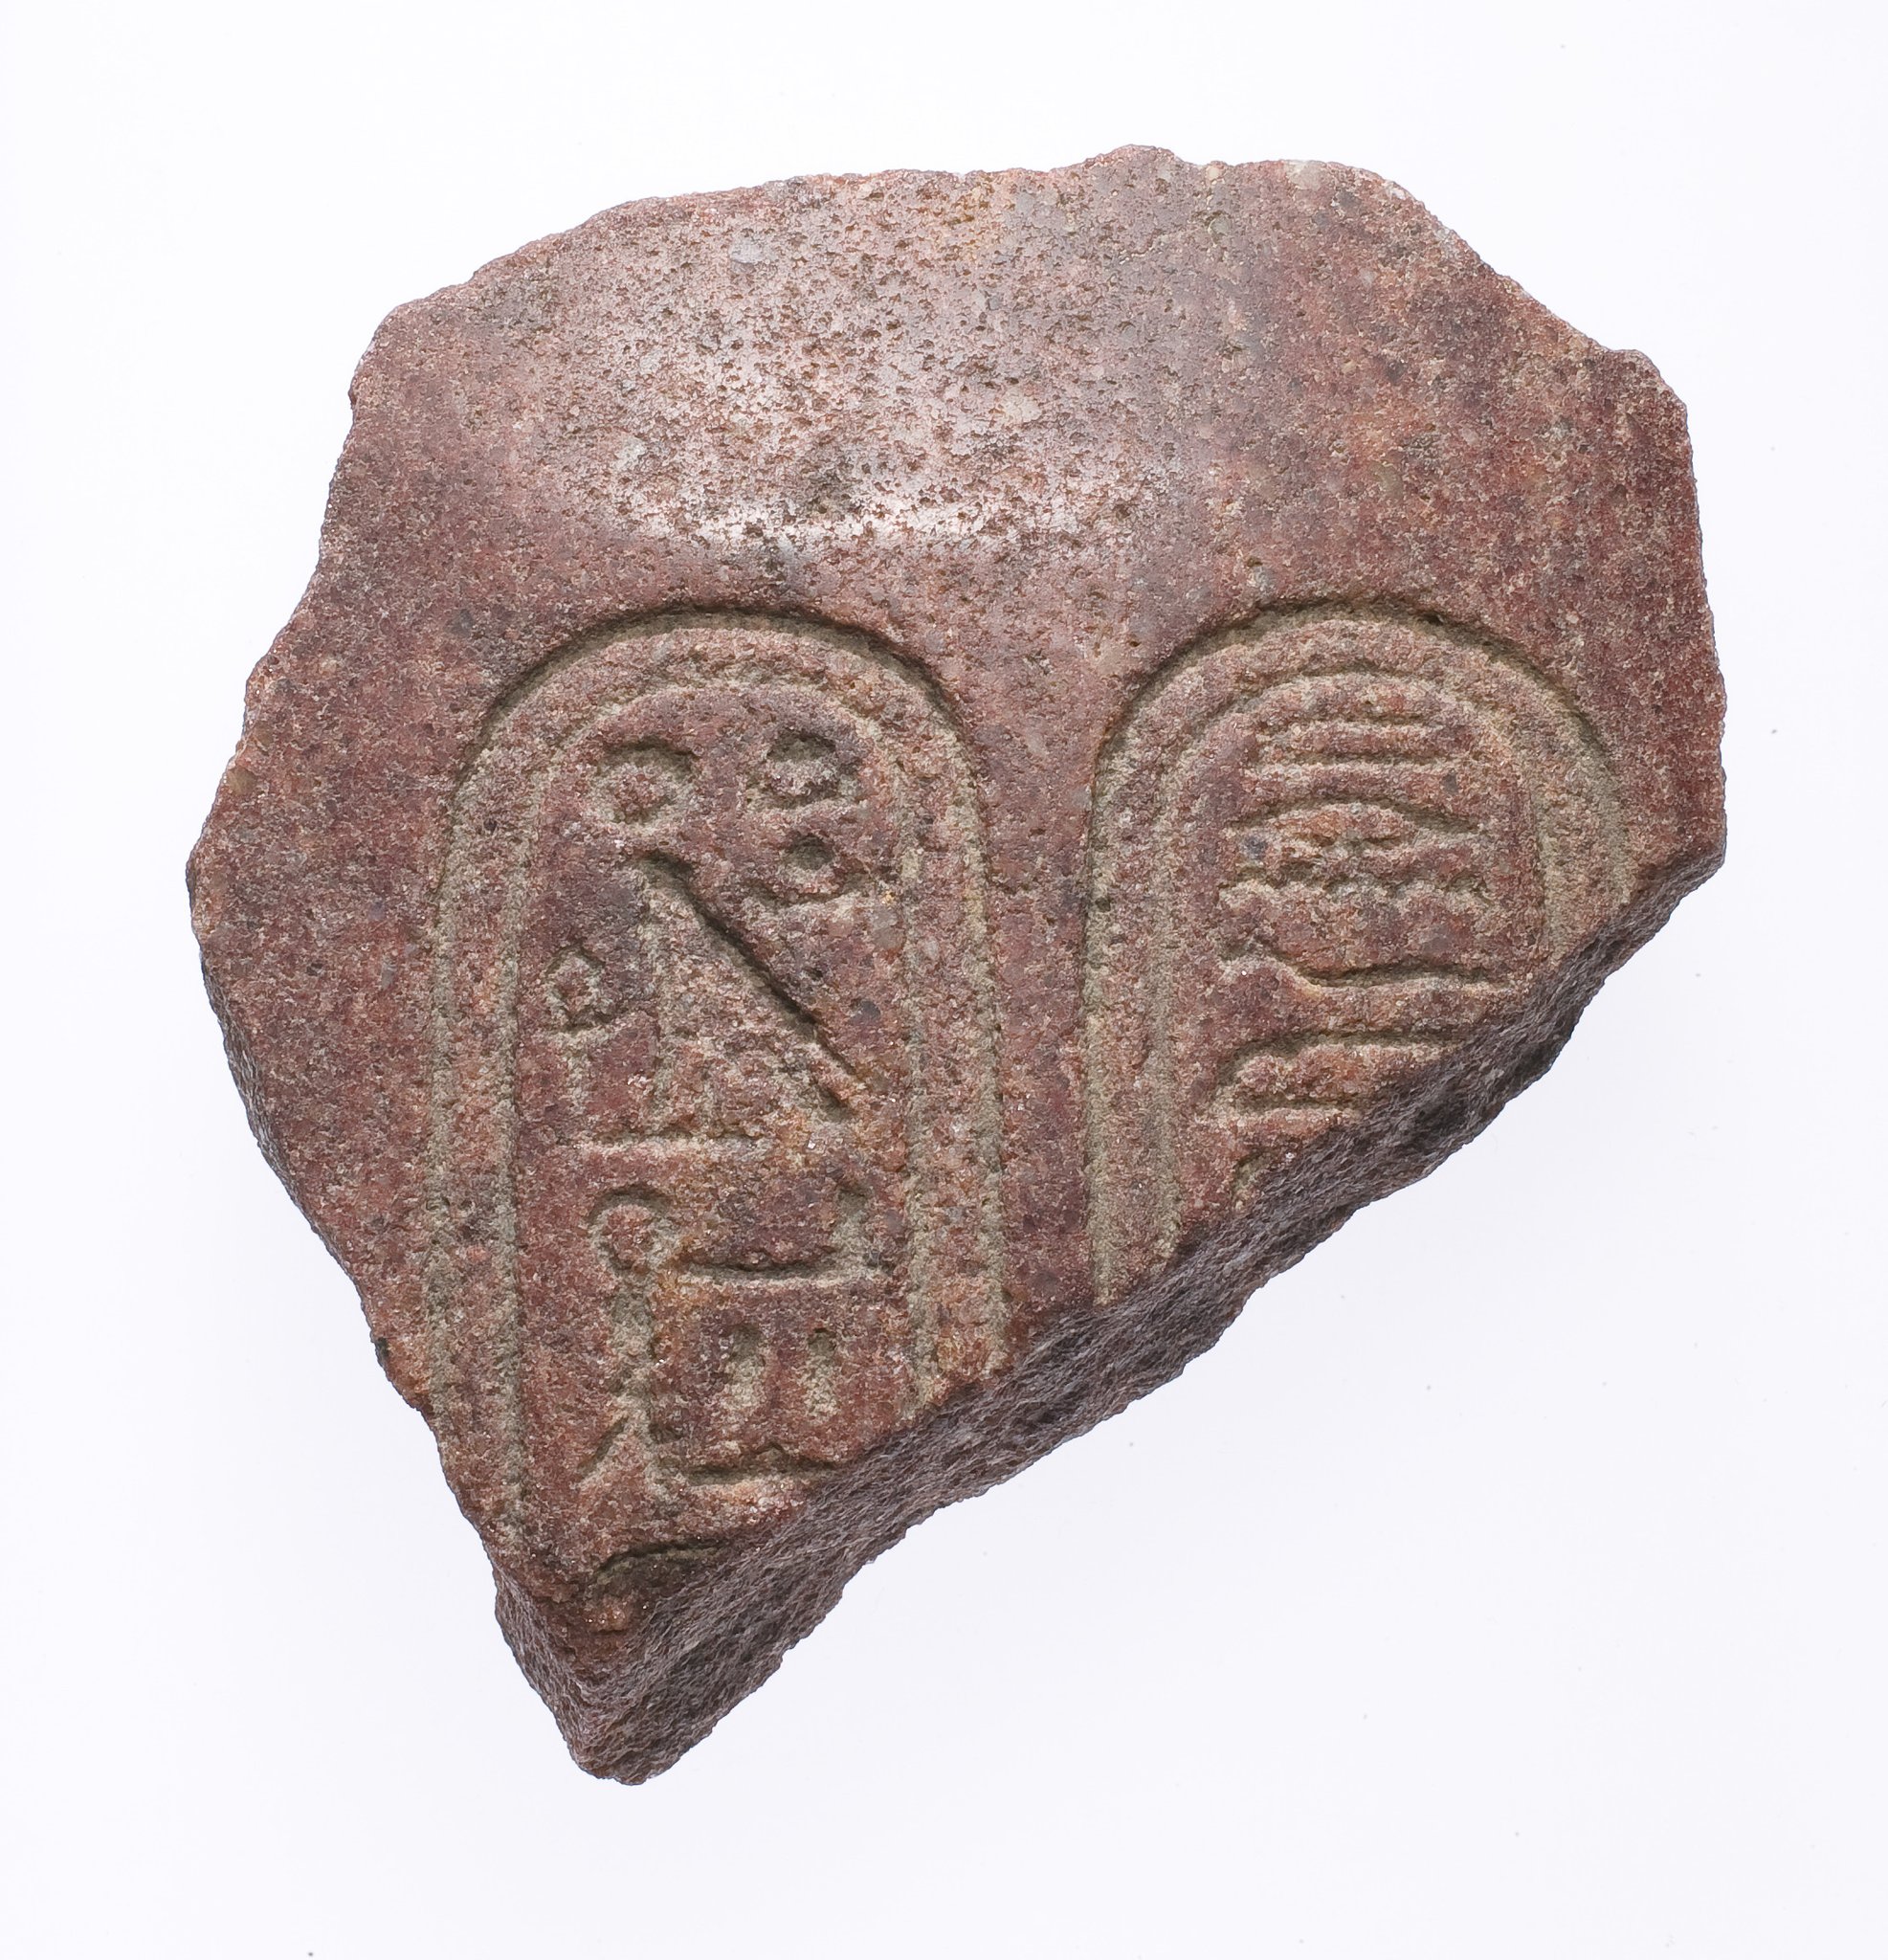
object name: chest, aten cartouch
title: Chest (?) fragment with Aten cartouches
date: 1353-1336 BCE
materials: quartzite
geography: egypt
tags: cartouches